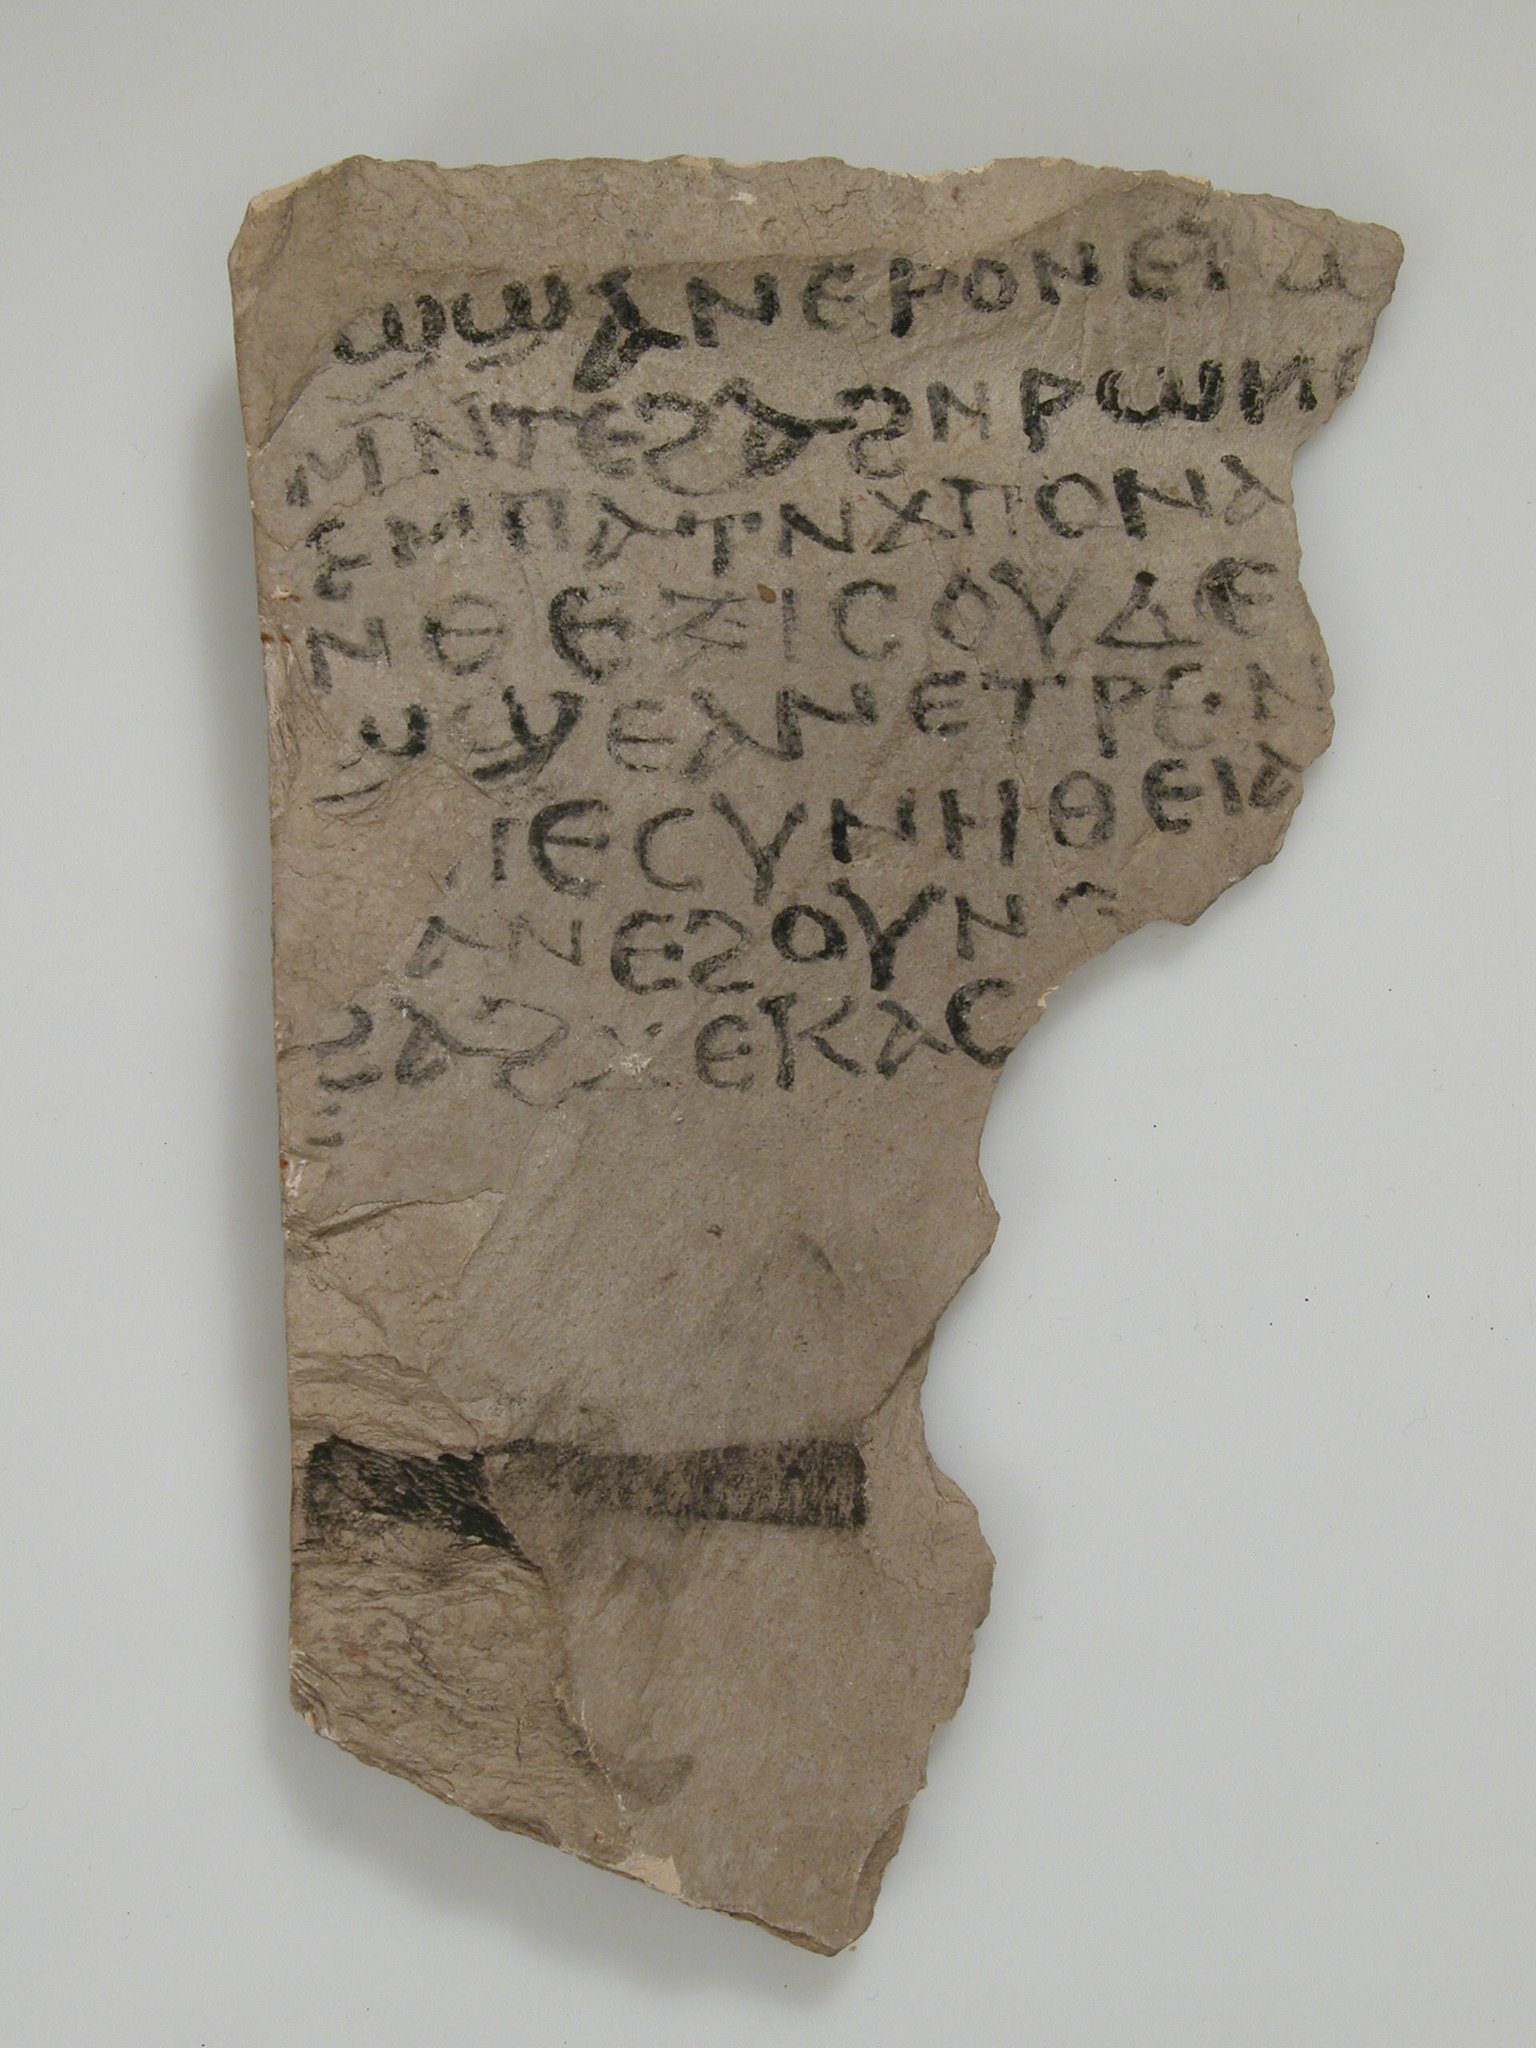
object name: ostrakon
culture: coptic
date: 601-700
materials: ink, limestone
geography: egypt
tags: documents